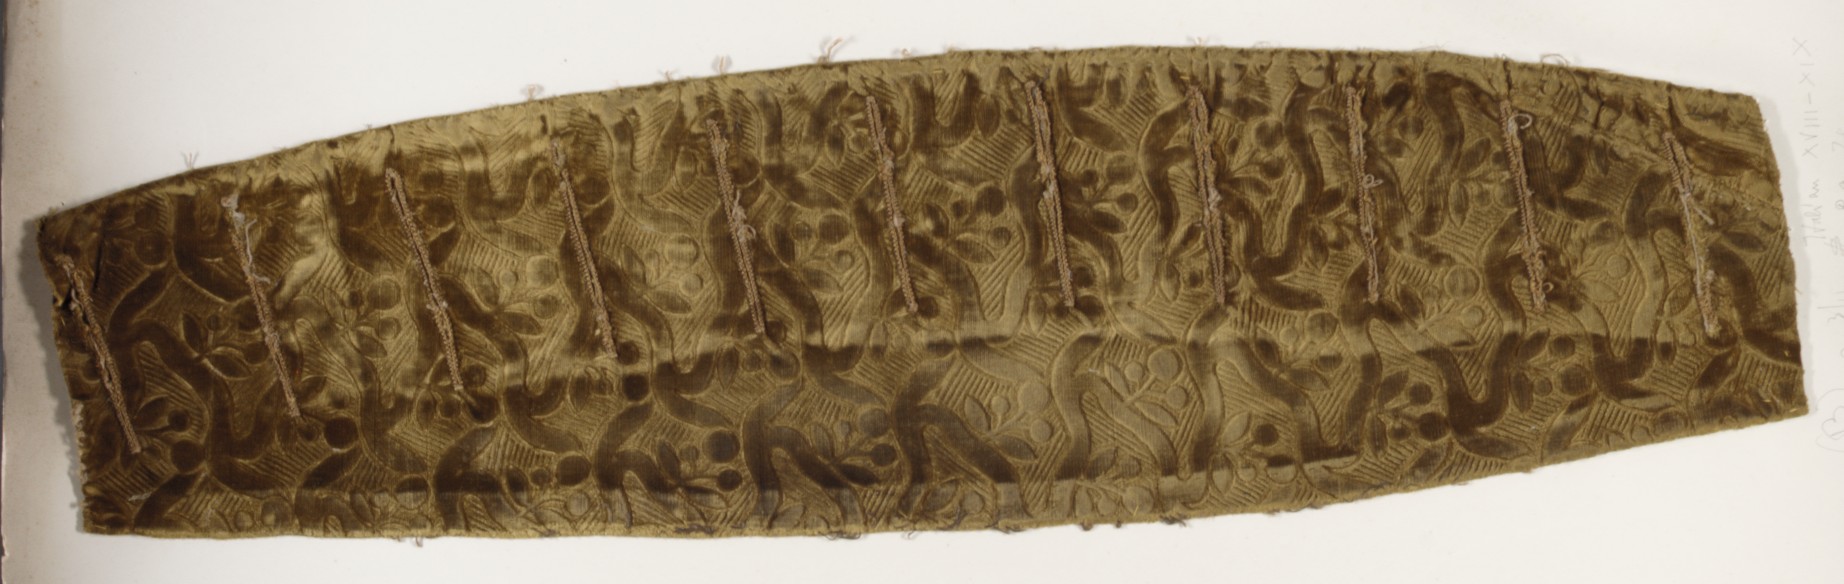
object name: fragment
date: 1701-1900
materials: silk